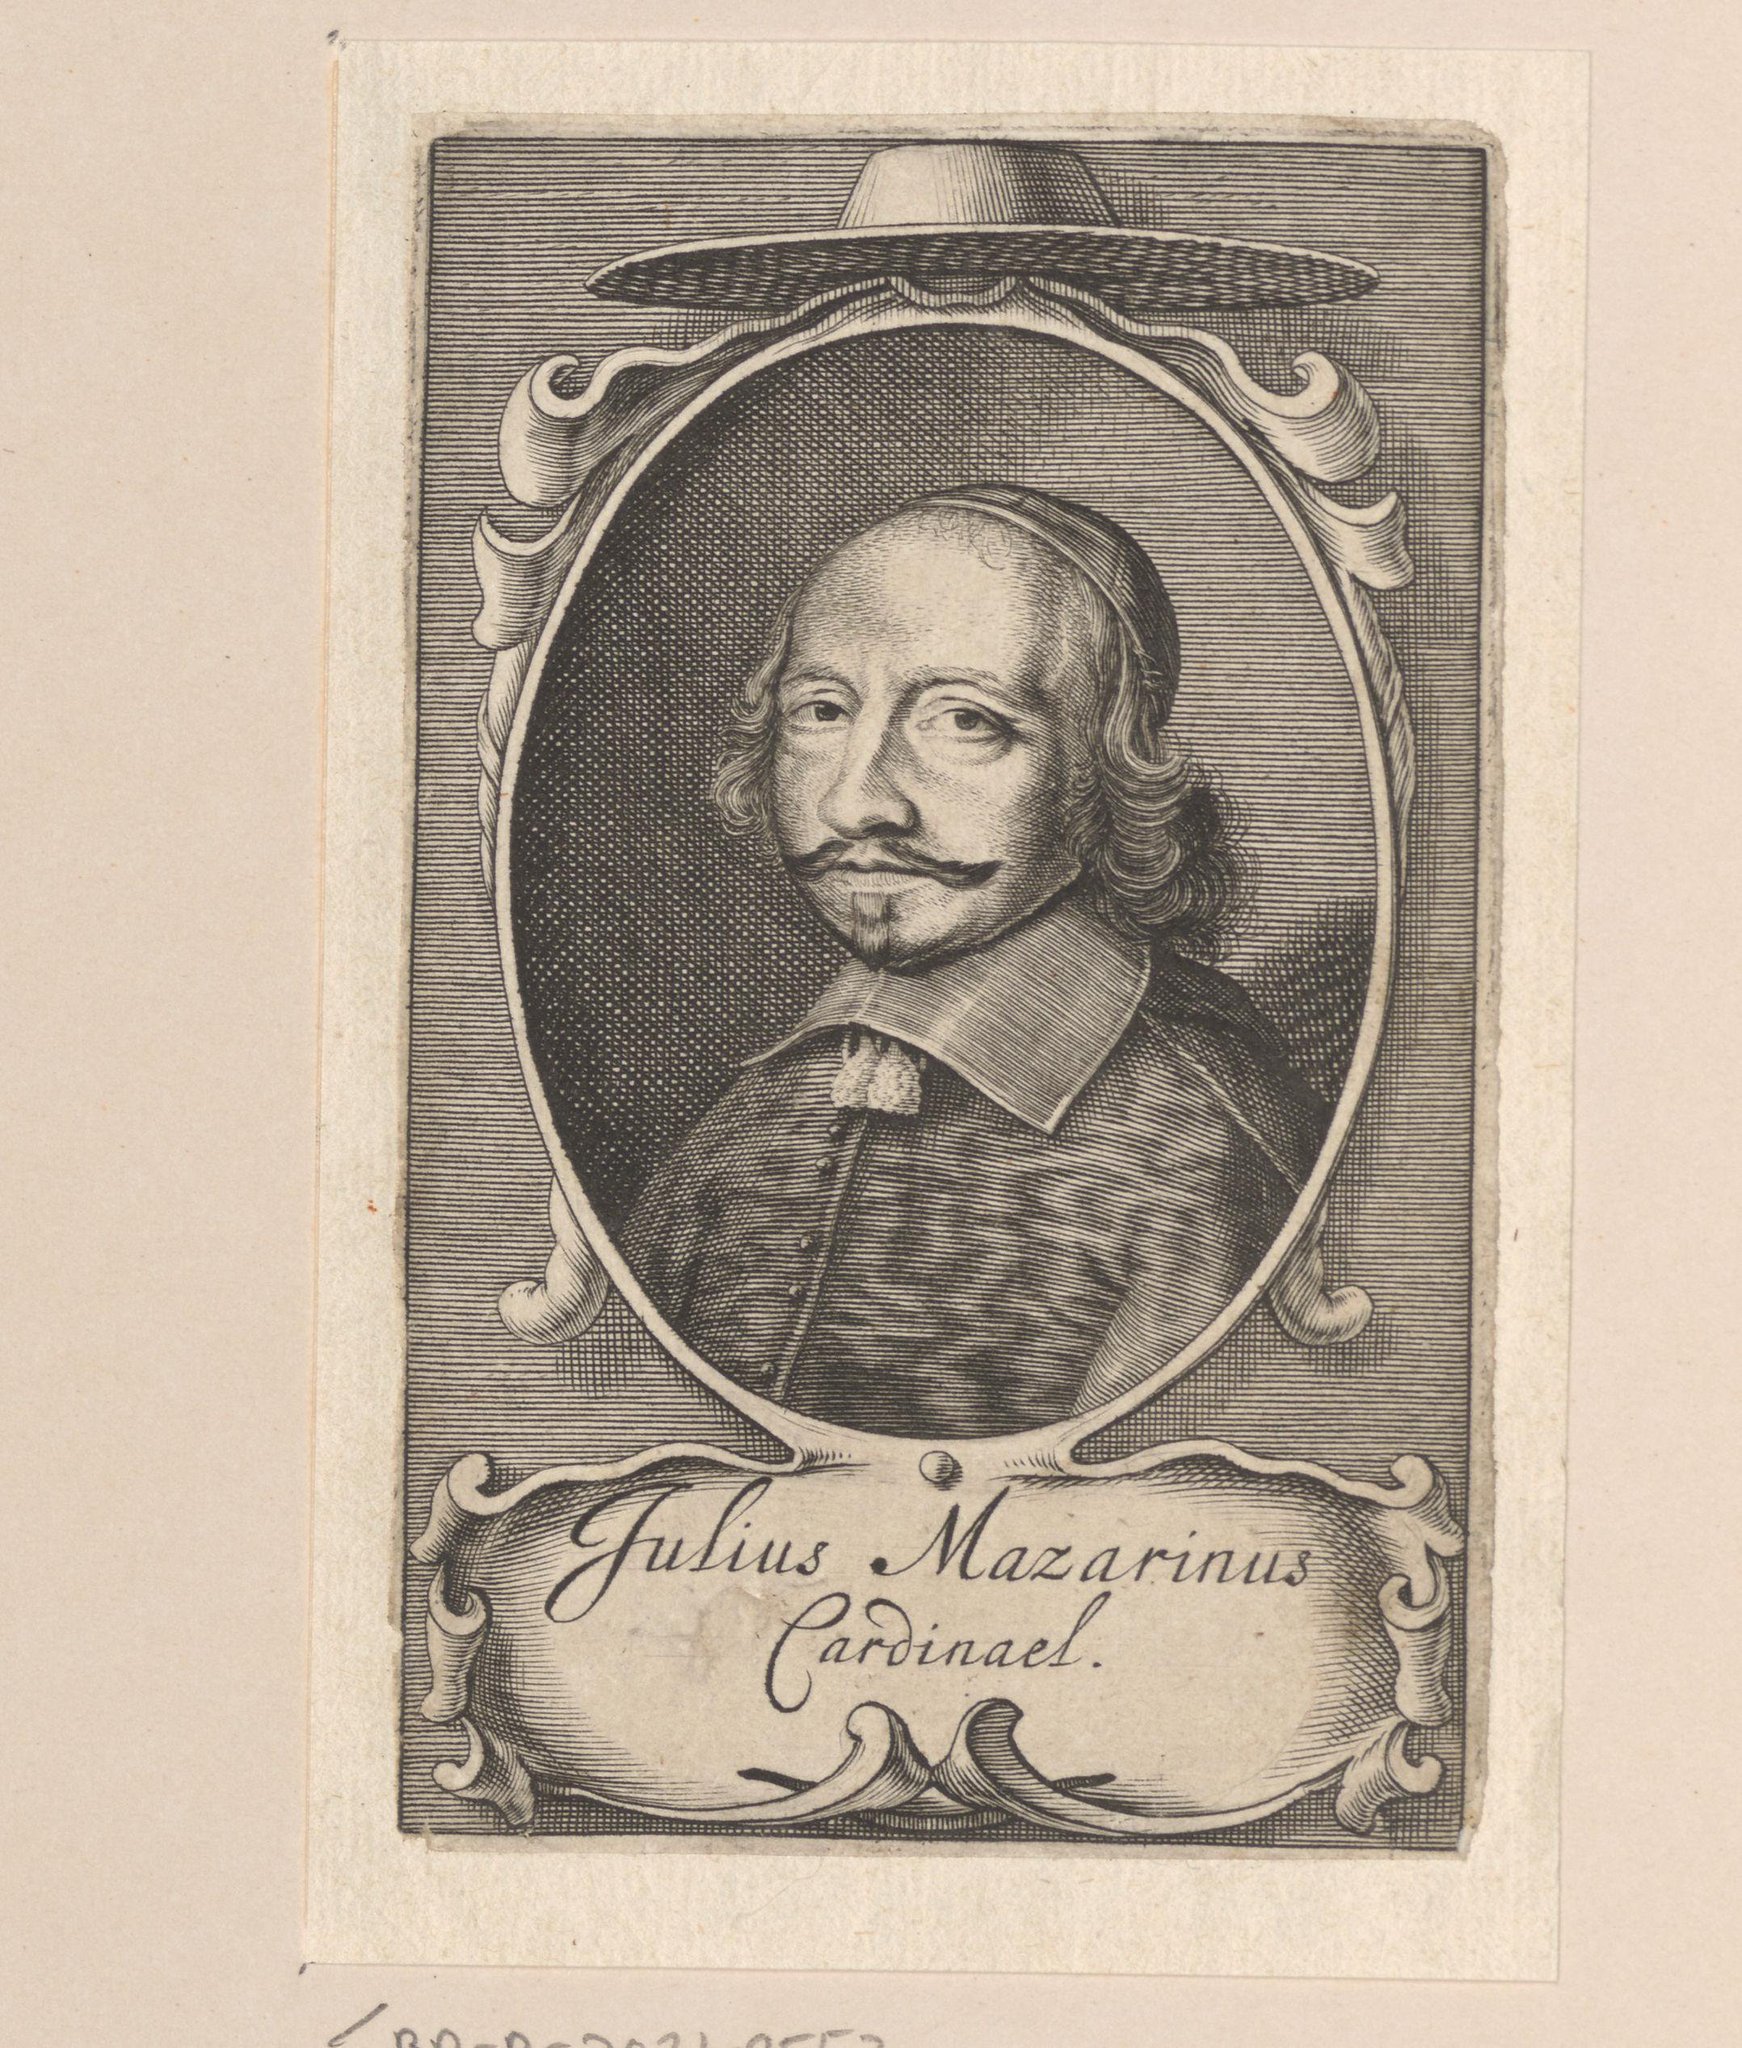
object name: print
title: Portret van Jules Mazarin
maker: Anonymous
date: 1661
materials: paper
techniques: engraving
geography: northern netherlands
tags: jules mazarin, cardinal, historical persons, insignia of cardinal, e.g. hat, mantle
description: Prent waarschijnlijk uit: Het leven en bedrijf van de Ed: Heer Cardinael Julius Mazarinus (...). Amsterdam: Johannes van den Bergh, 1661.